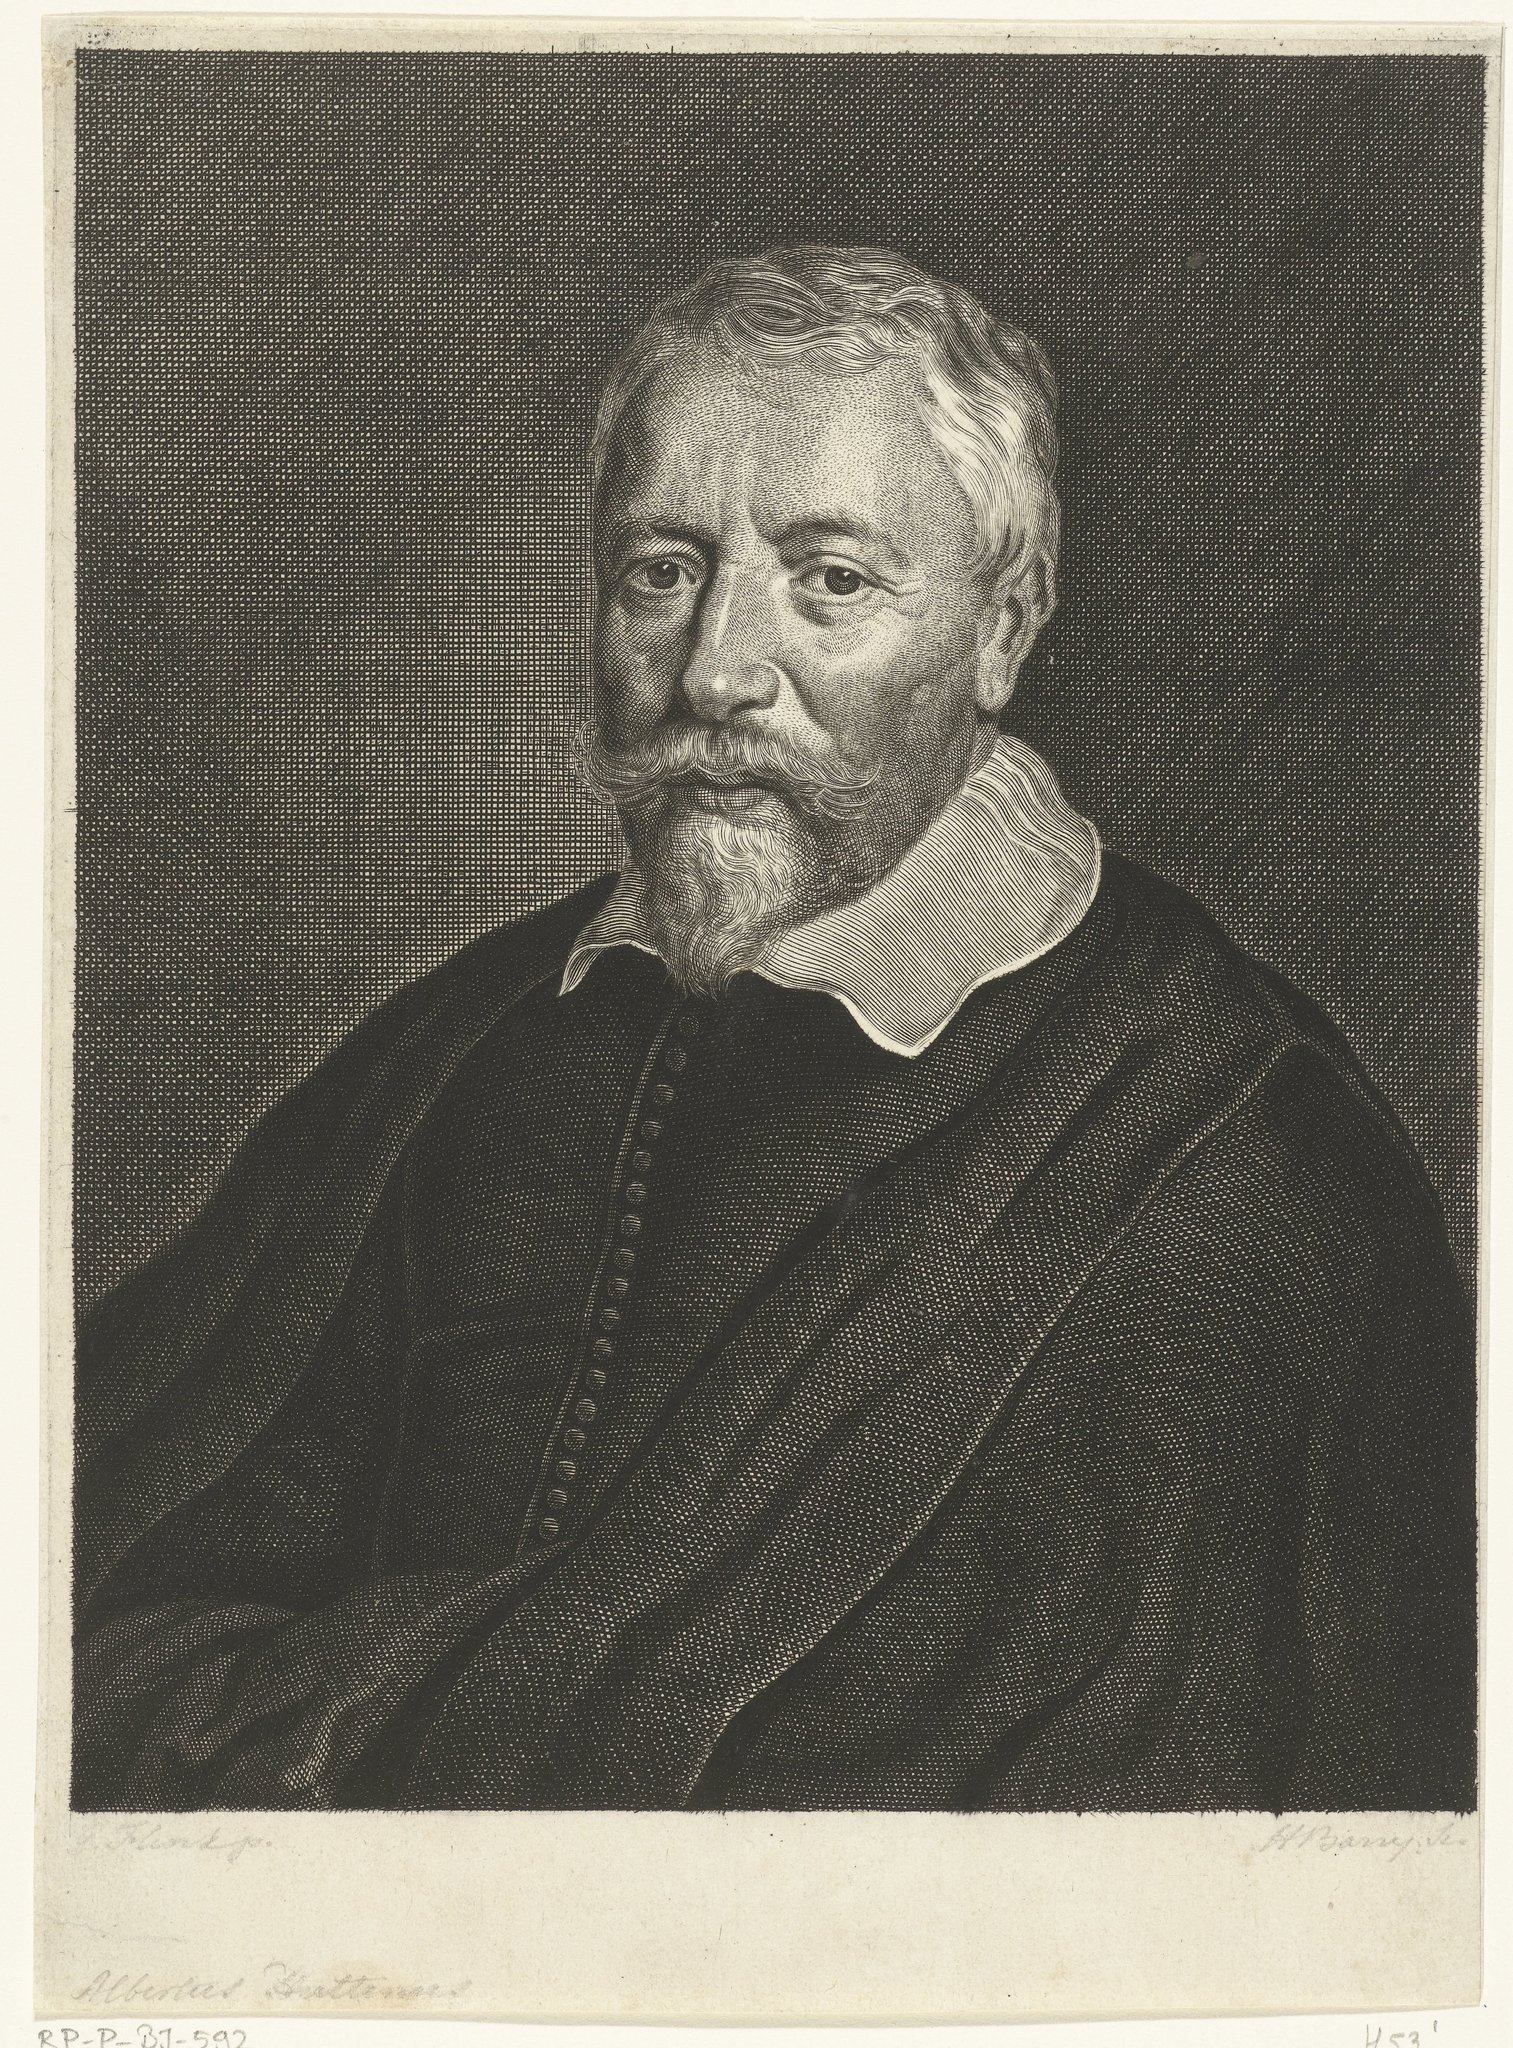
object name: print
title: Portret van Albertus Huttenus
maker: hendrik bary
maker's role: draughtsman, print maker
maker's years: 1640-1707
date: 1657-1707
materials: paper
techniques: engraving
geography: netherlands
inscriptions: collector's mark: Lugt 2228